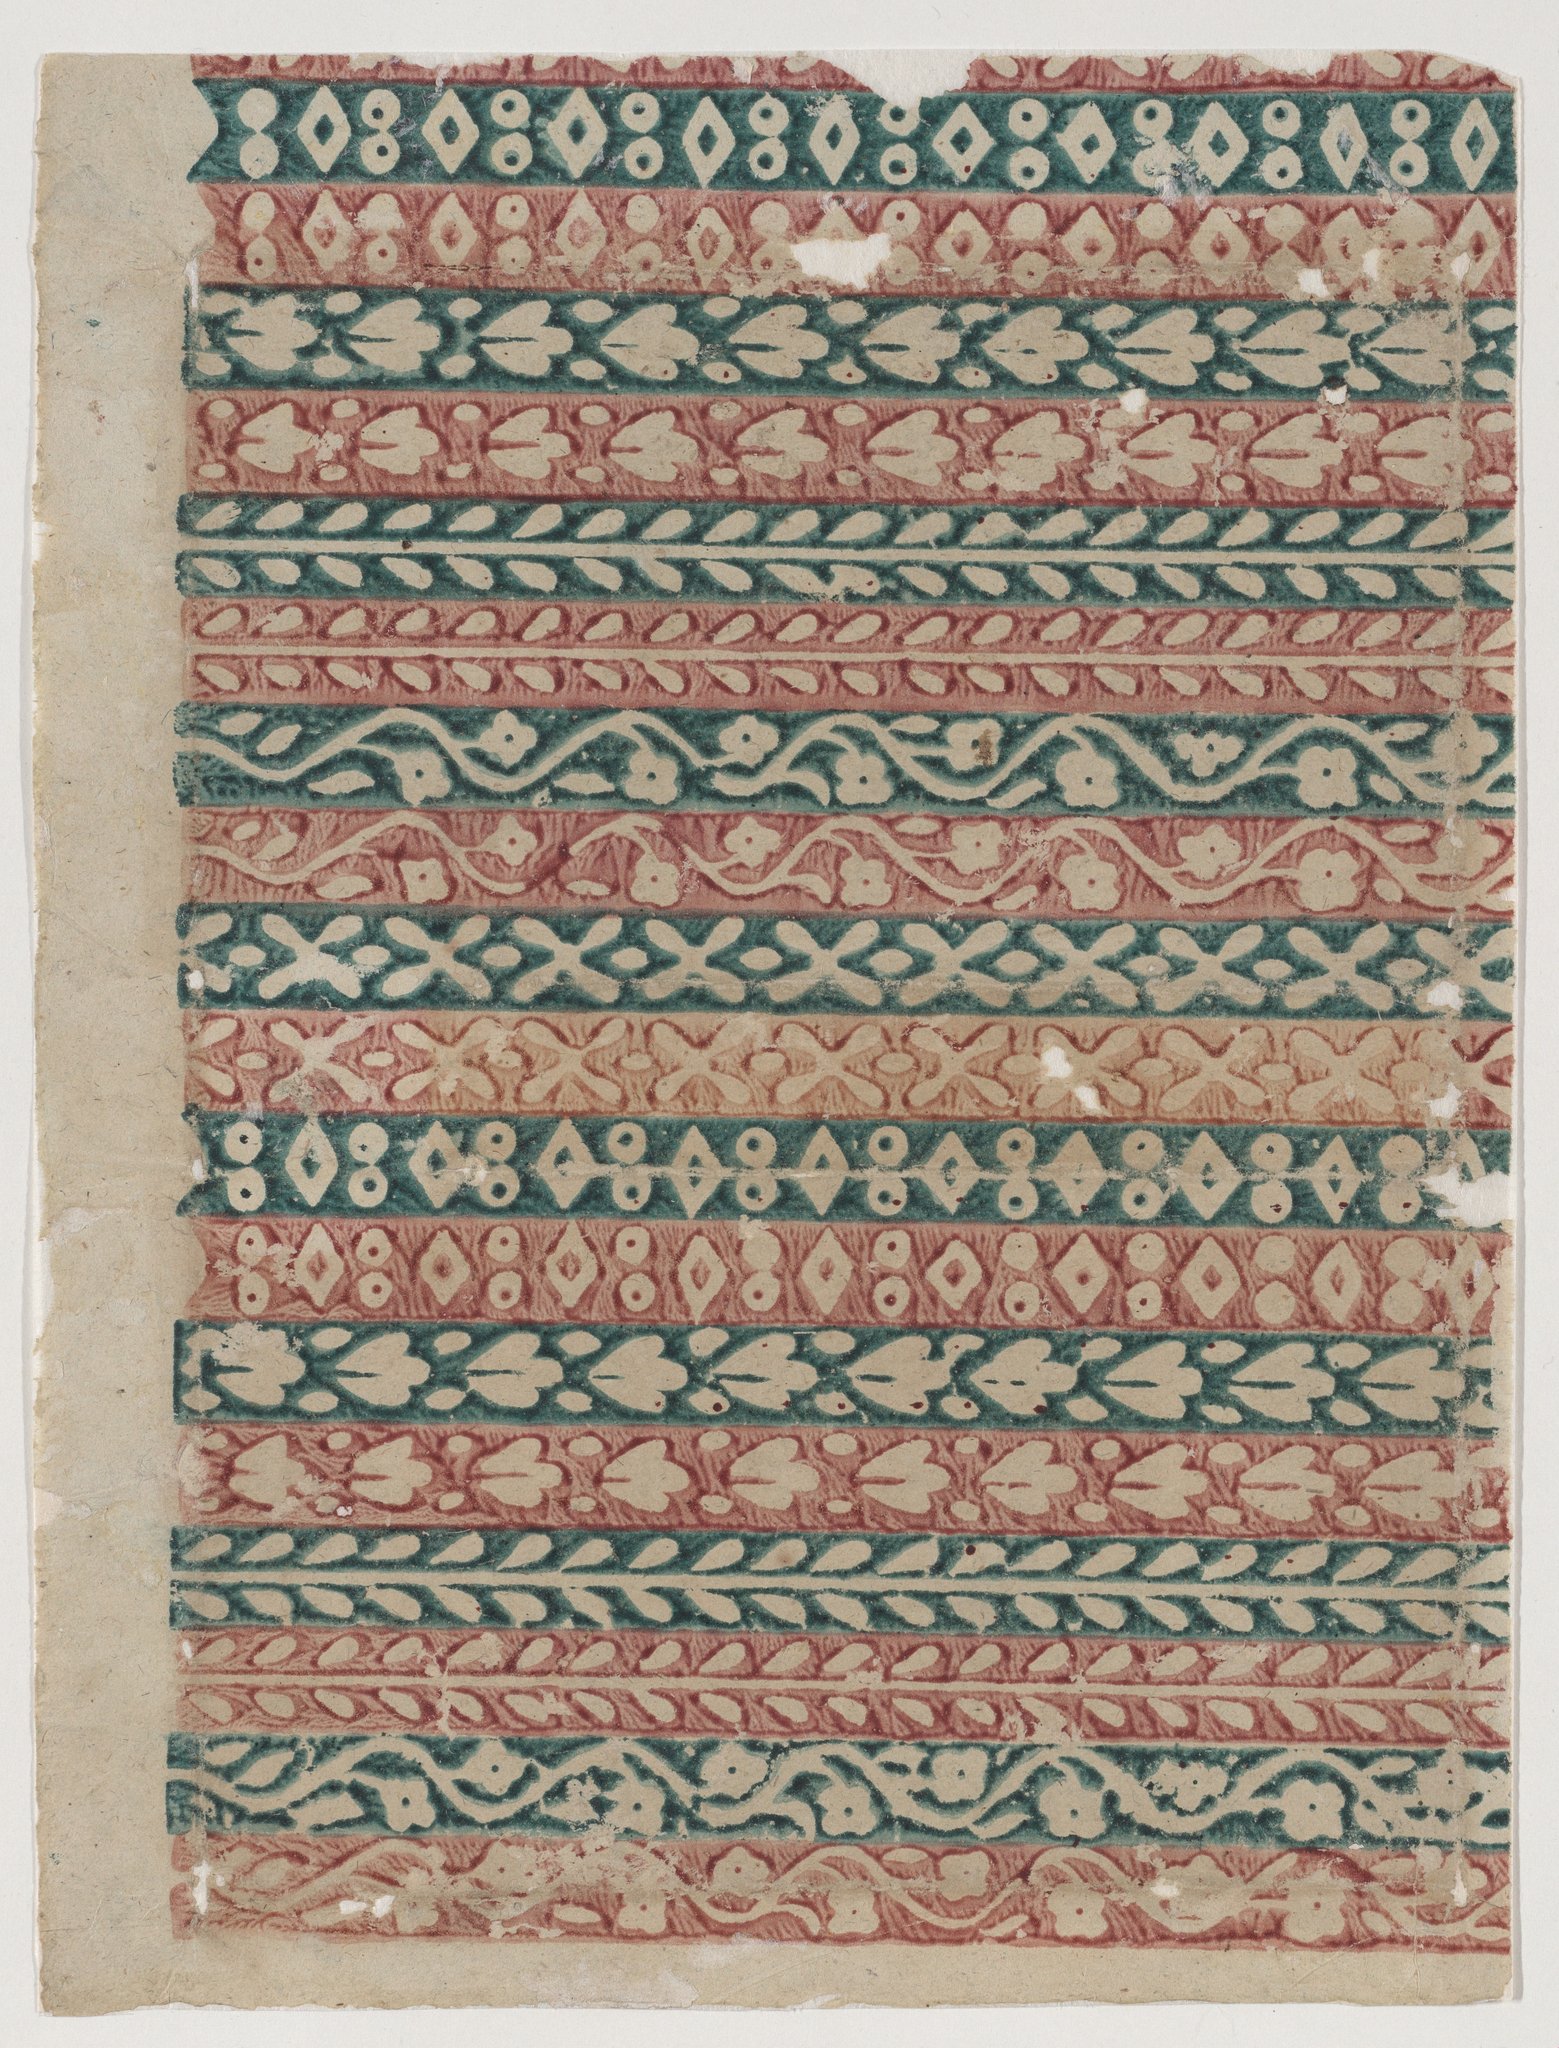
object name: print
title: Sheet with floral and geometric borders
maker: Anonymous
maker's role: artist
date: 1801-1900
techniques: relief print